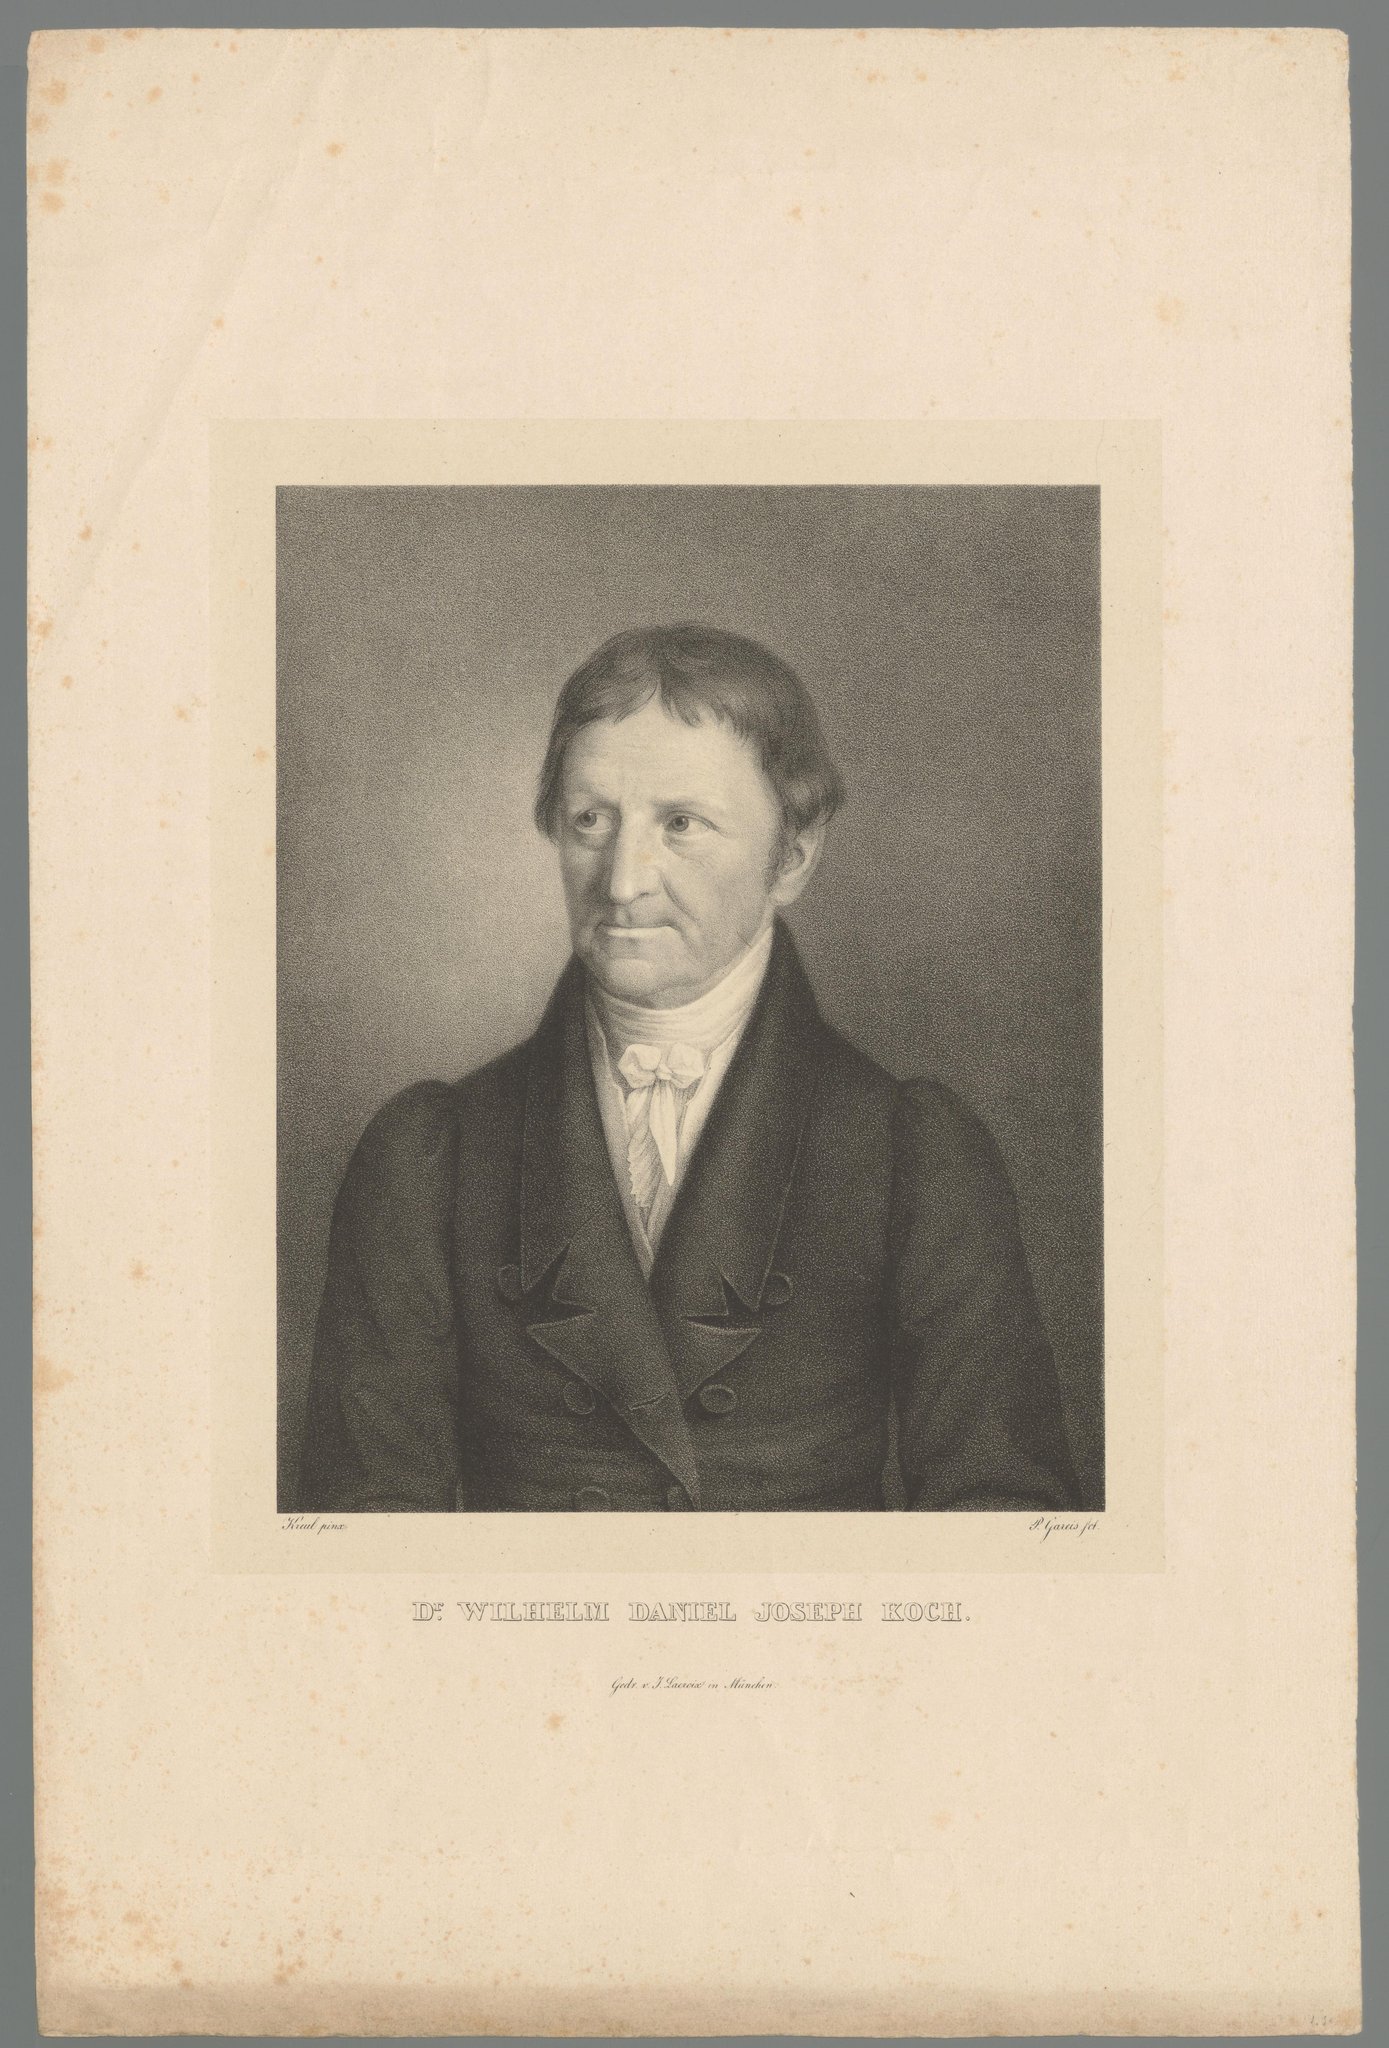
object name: print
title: Portret van Wilhelm Daniel Joseph Koch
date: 1813-1879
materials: paper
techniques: lithograph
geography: munich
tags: adult man, historical persons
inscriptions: collector's mark: Lugt 2228